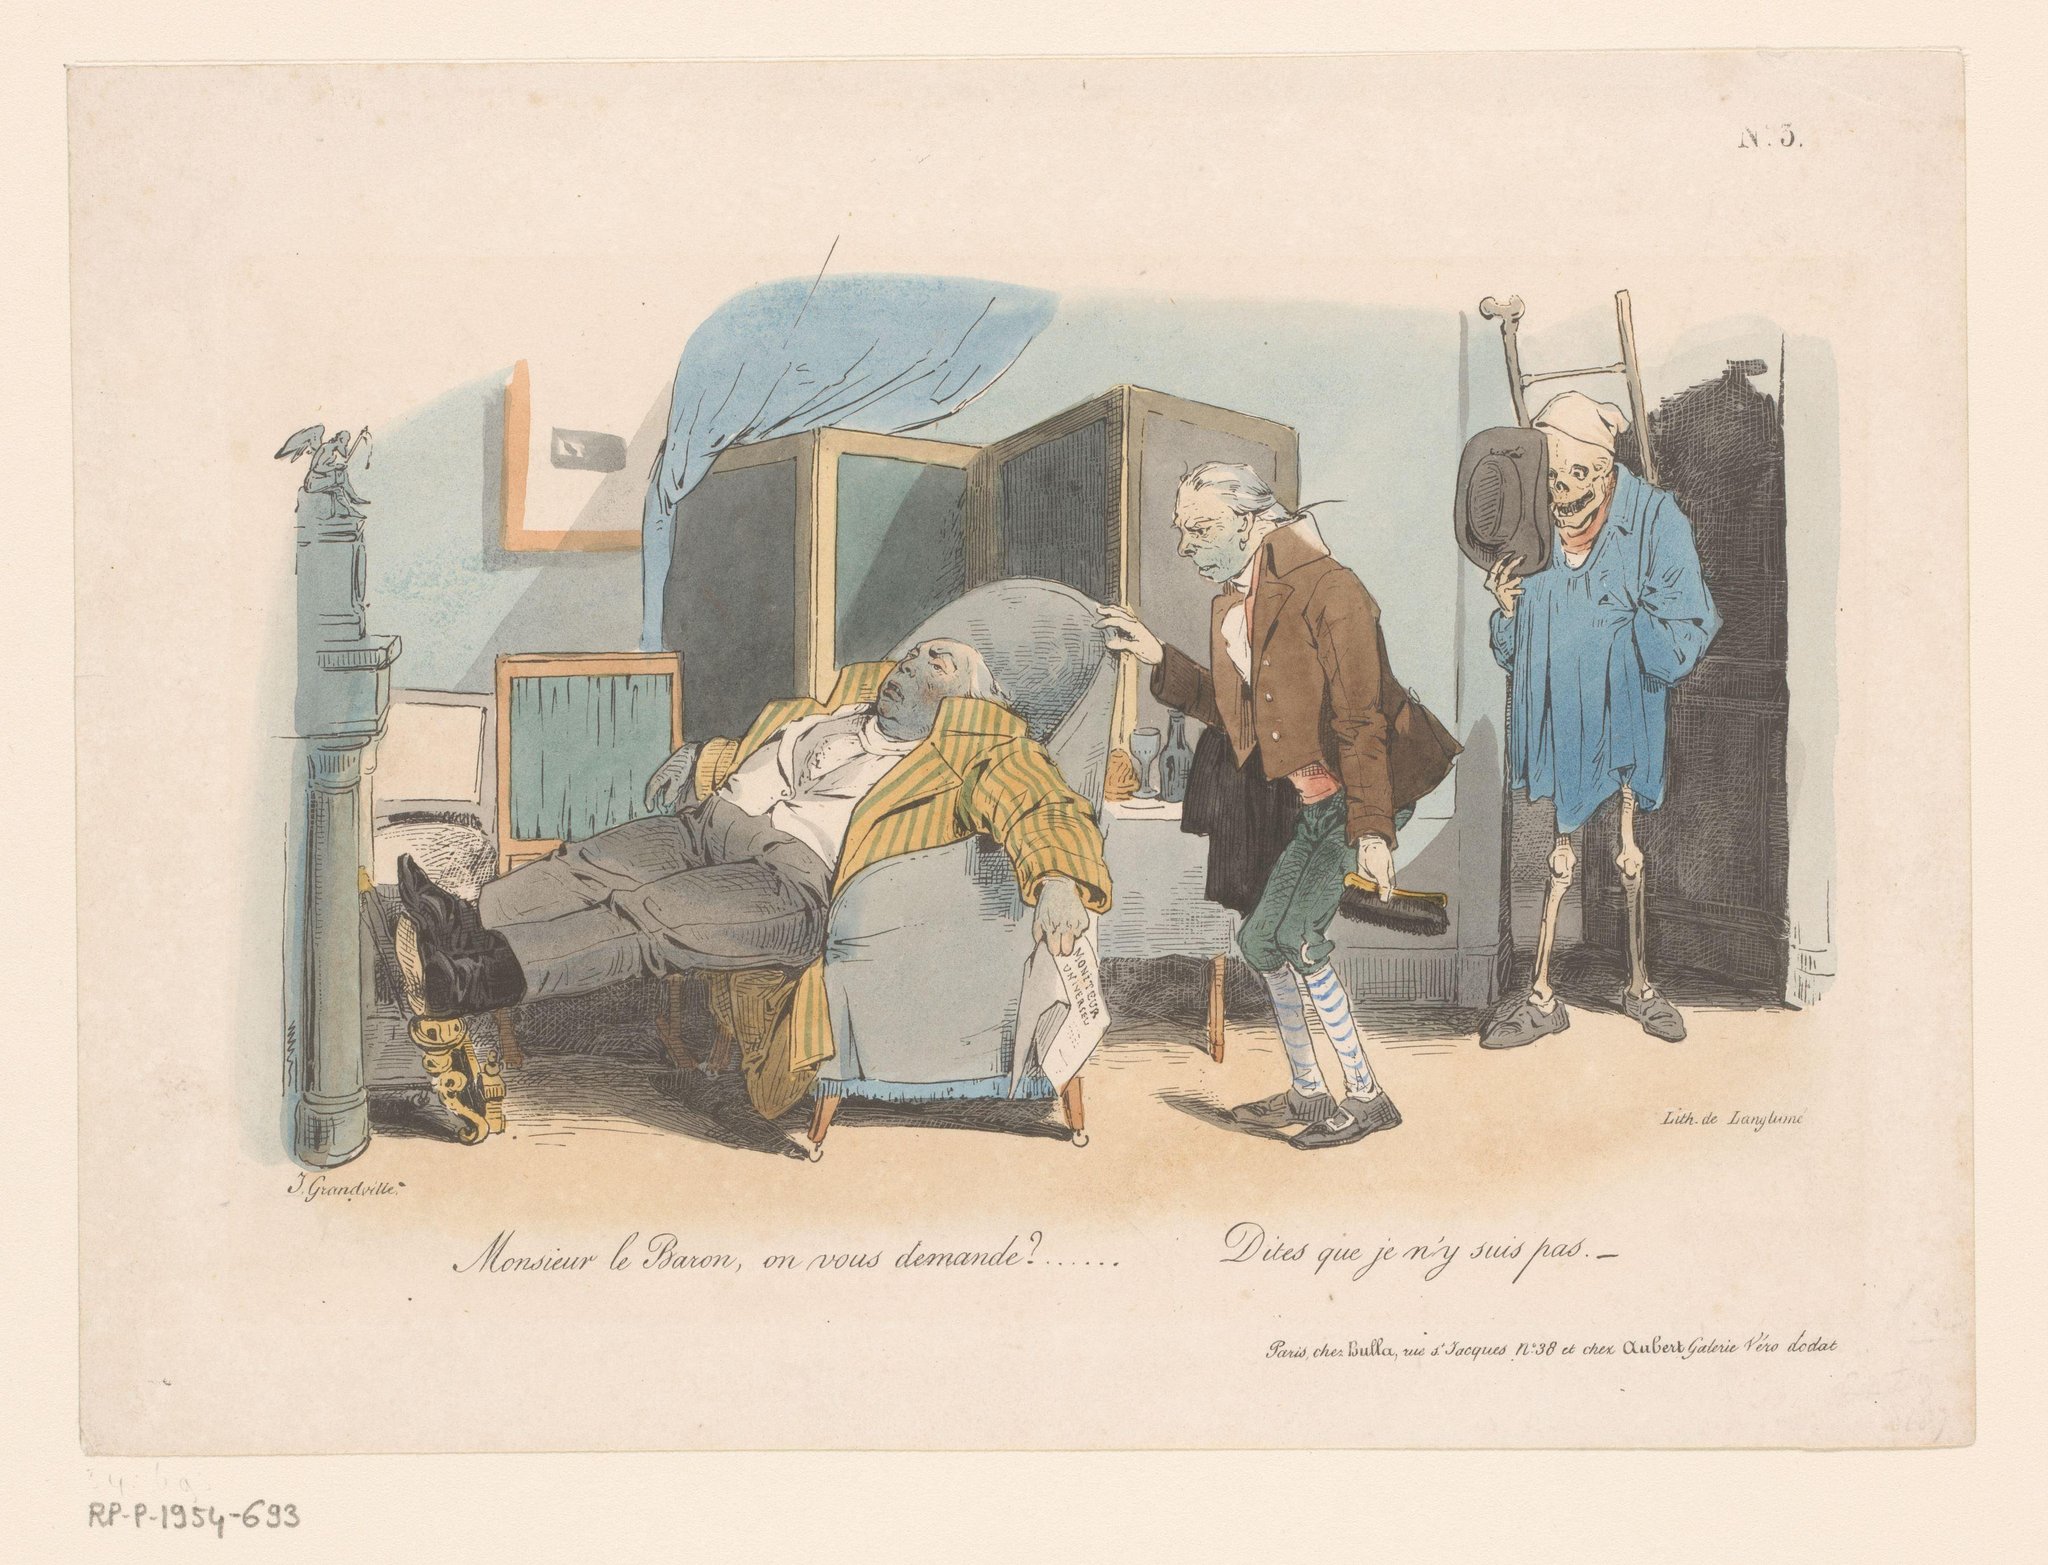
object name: print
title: Monsieur le Baron, on vous demande? (...)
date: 1830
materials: paper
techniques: hand coloring, lithograph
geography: paris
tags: death as skeleton, dying, grave digger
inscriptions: collector's mark: Lugt 2228a, collector's mark: Lugt 2760